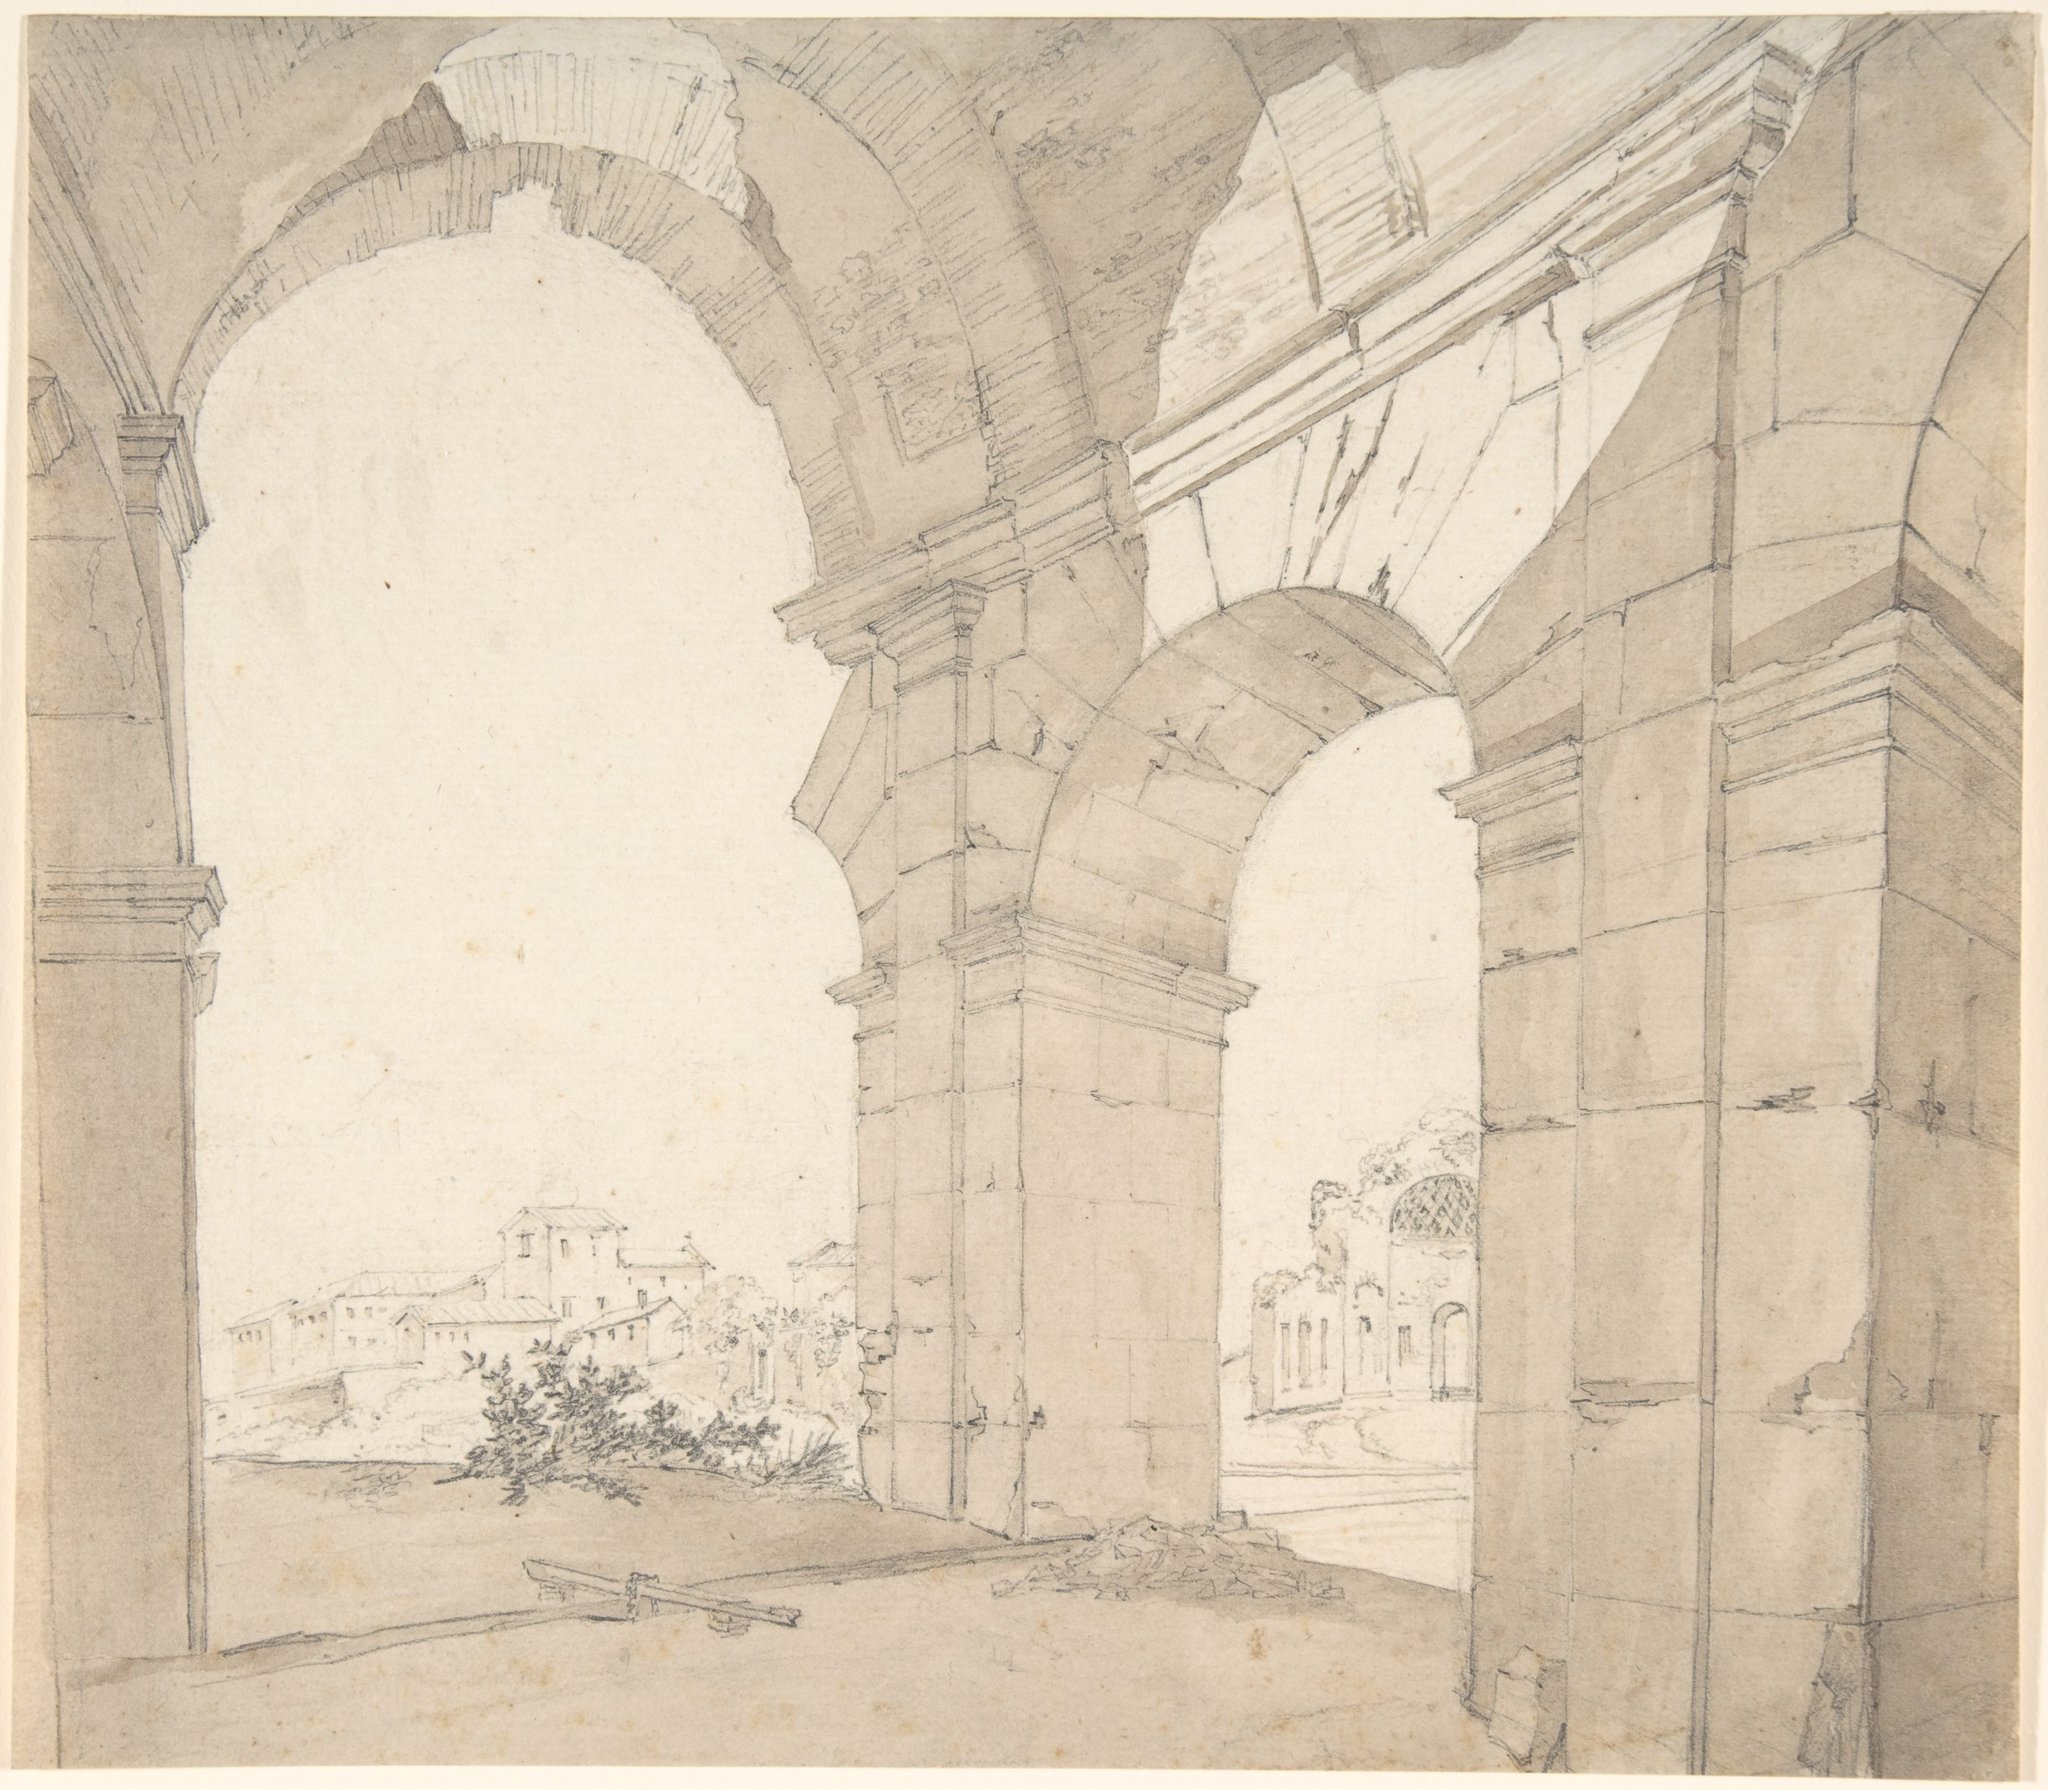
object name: drawing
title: View of the Baths of Caracalla (?) in Rome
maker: daniël dupré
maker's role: artist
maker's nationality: dutch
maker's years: 1751-1817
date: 1767-1833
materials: graphite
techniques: wash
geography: netherlands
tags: ruins